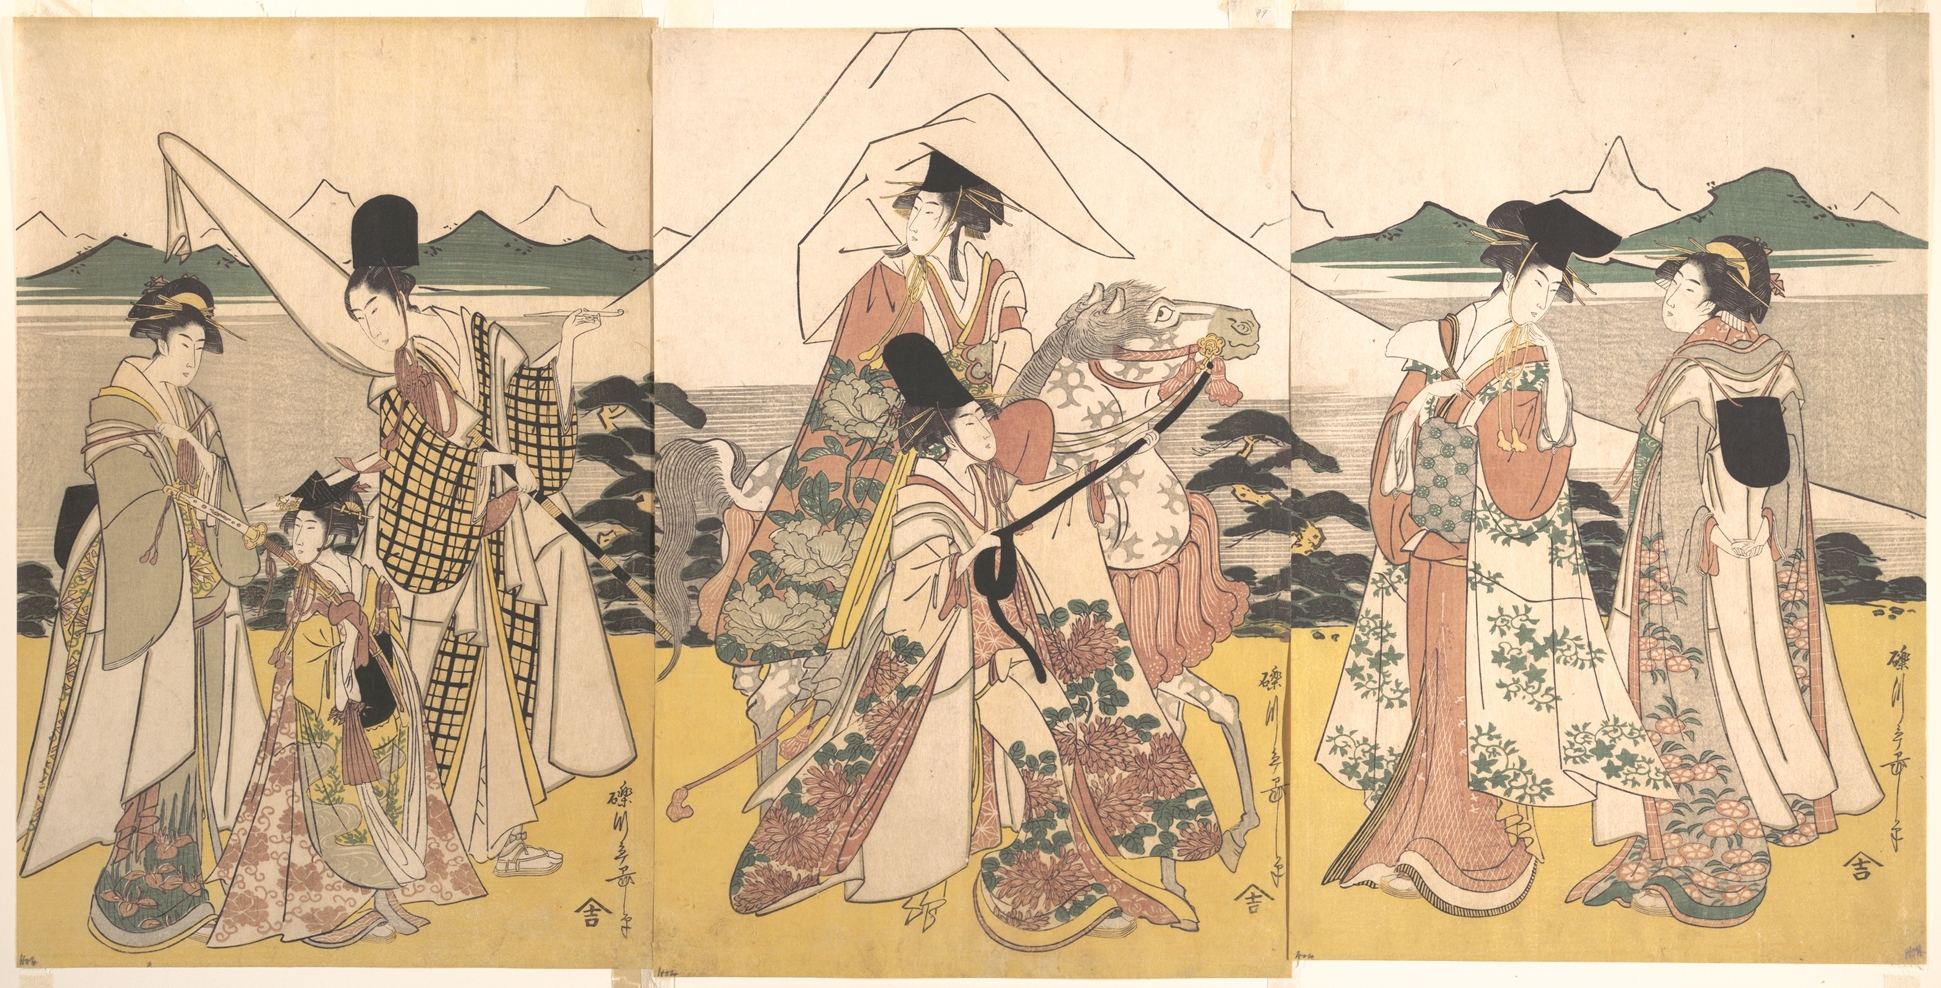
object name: print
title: Narihira's Journey to the East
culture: japanese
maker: rekisentei eiri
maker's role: artist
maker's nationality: japanese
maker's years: 1789-1801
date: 1767-1800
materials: ink, paper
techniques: woodblock print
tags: women,horses,mountains